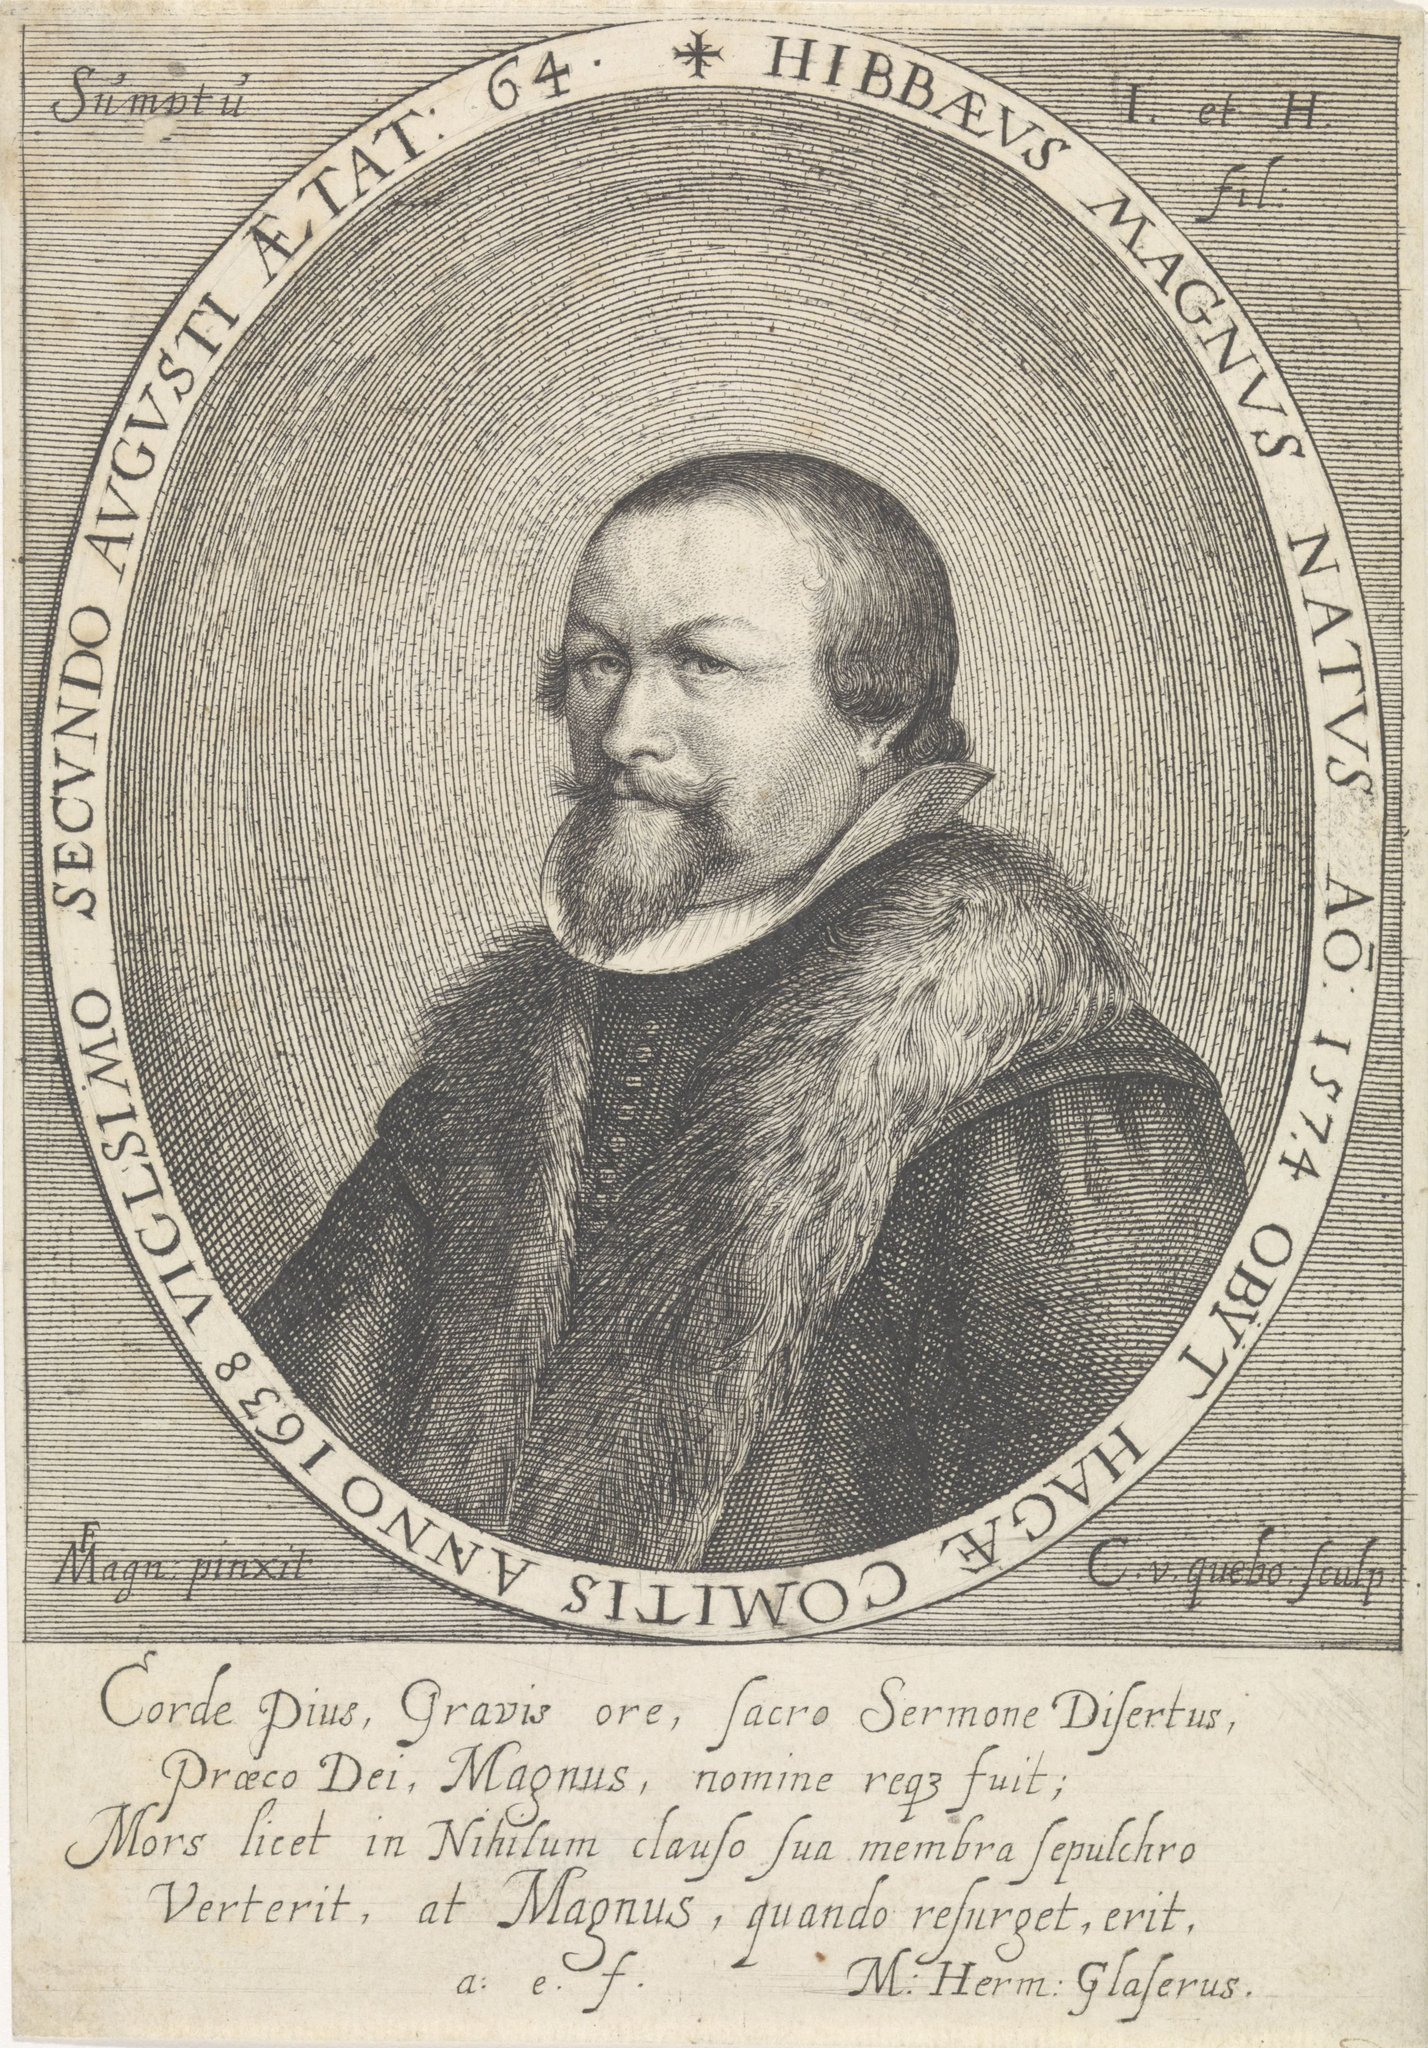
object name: print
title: Portret van Hibbaeus Magnus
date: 1638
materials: paper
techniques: engraving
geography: the hague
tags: the hague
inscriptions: collector's mark: Lugt 2228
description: Portret van de predikant Hibbaeus Magnus, ter gelegenheid van zijn overlijden op 64-jarige leeftijd. In de marge een vierregelig onderschrift in het Latijn.